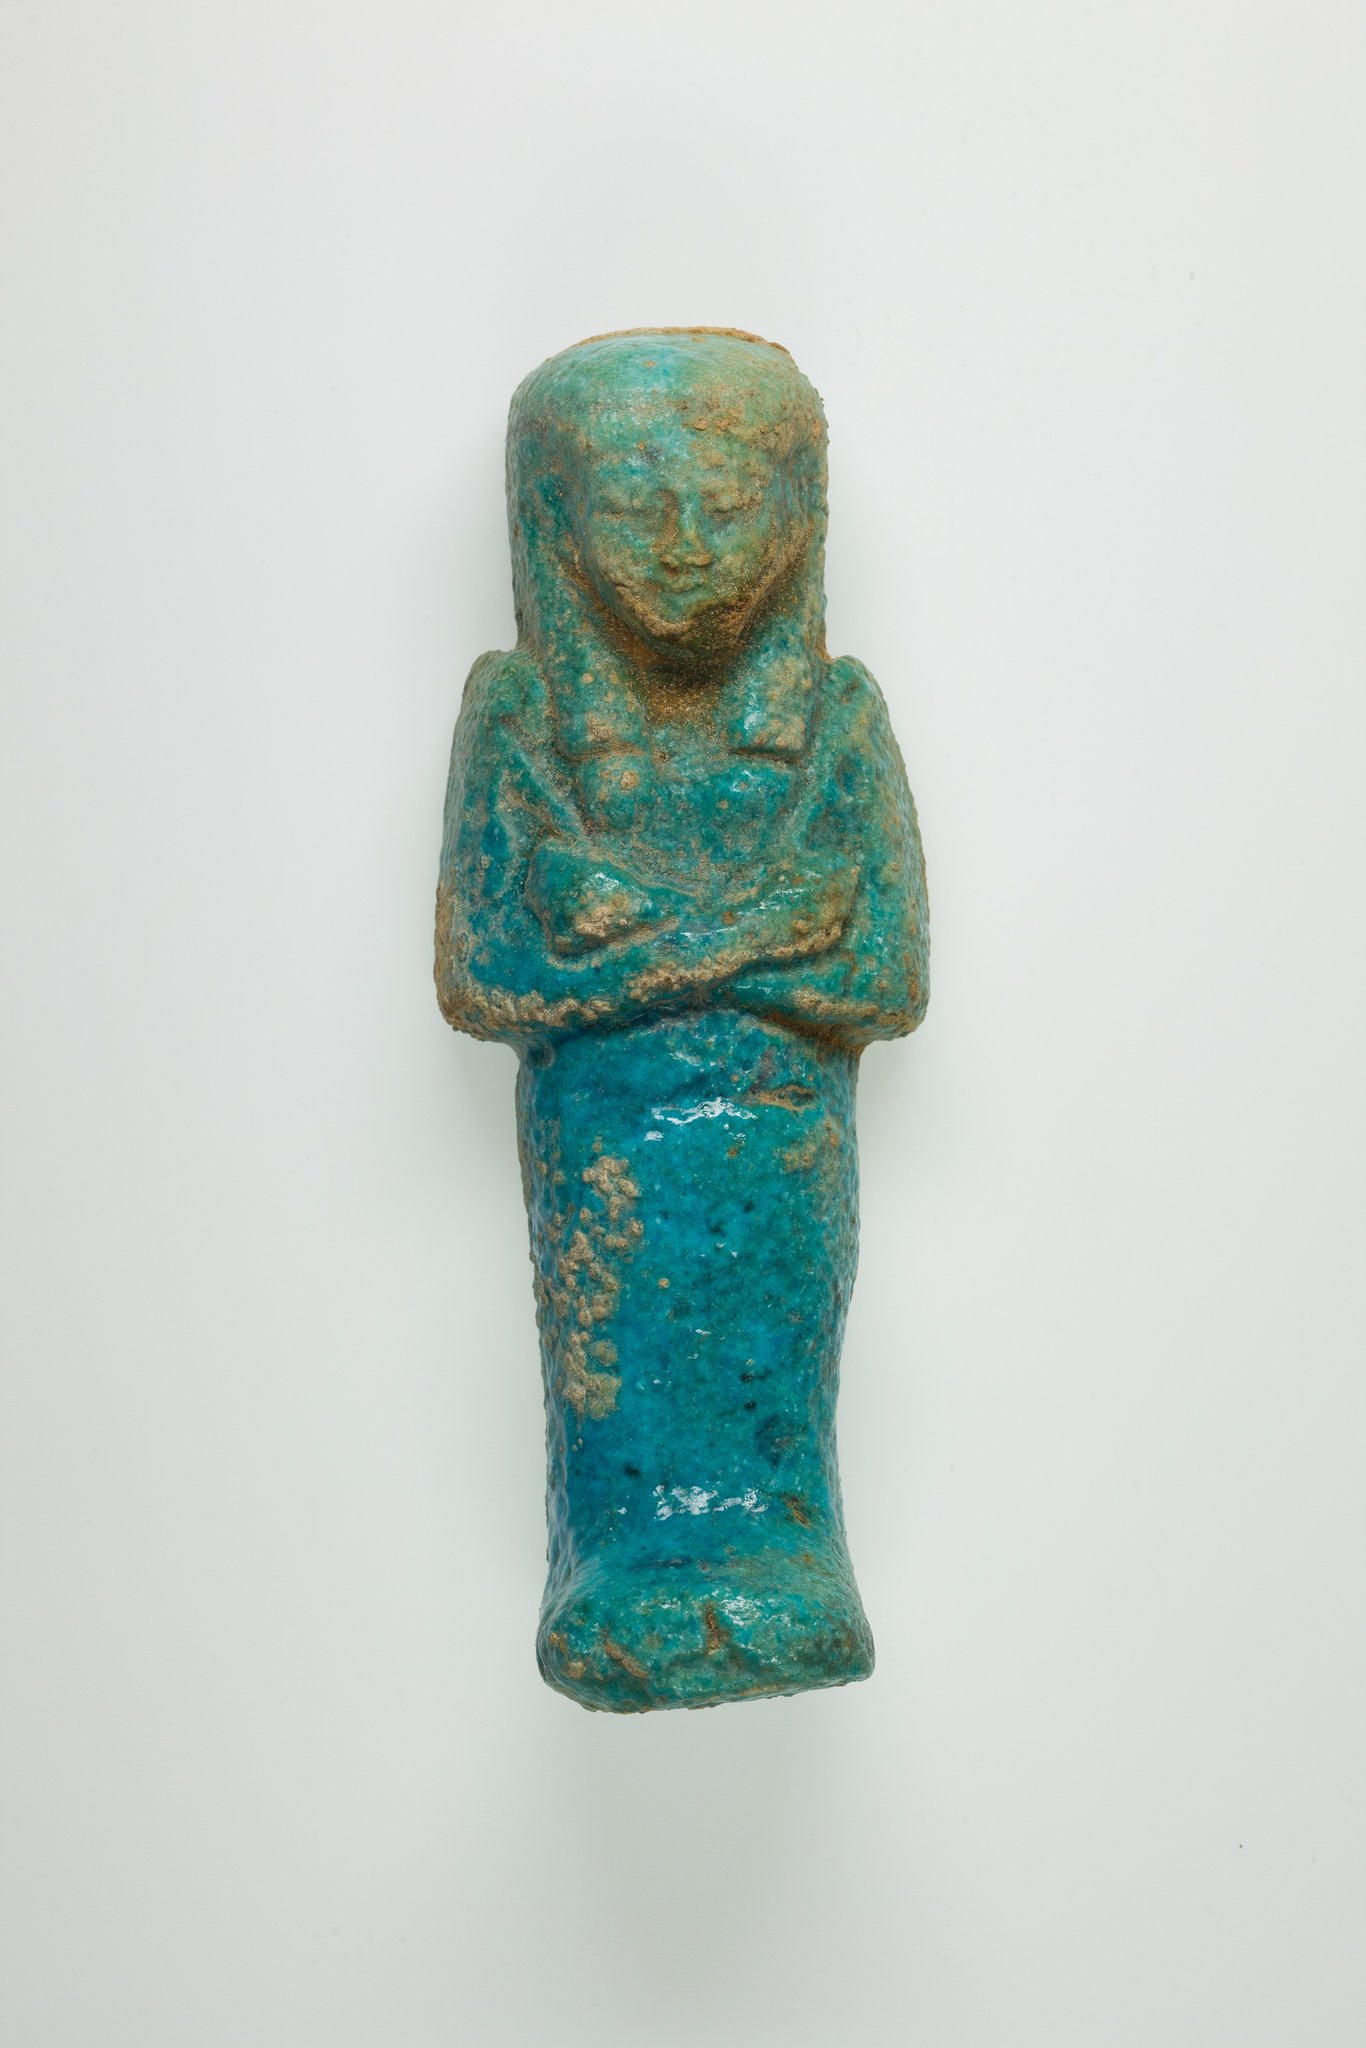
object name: shabti, henettawy c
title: Worker Shabti of Henettawy (C), Daughter of Isetemkheb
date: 990-970 BCE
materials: faience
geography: egypt